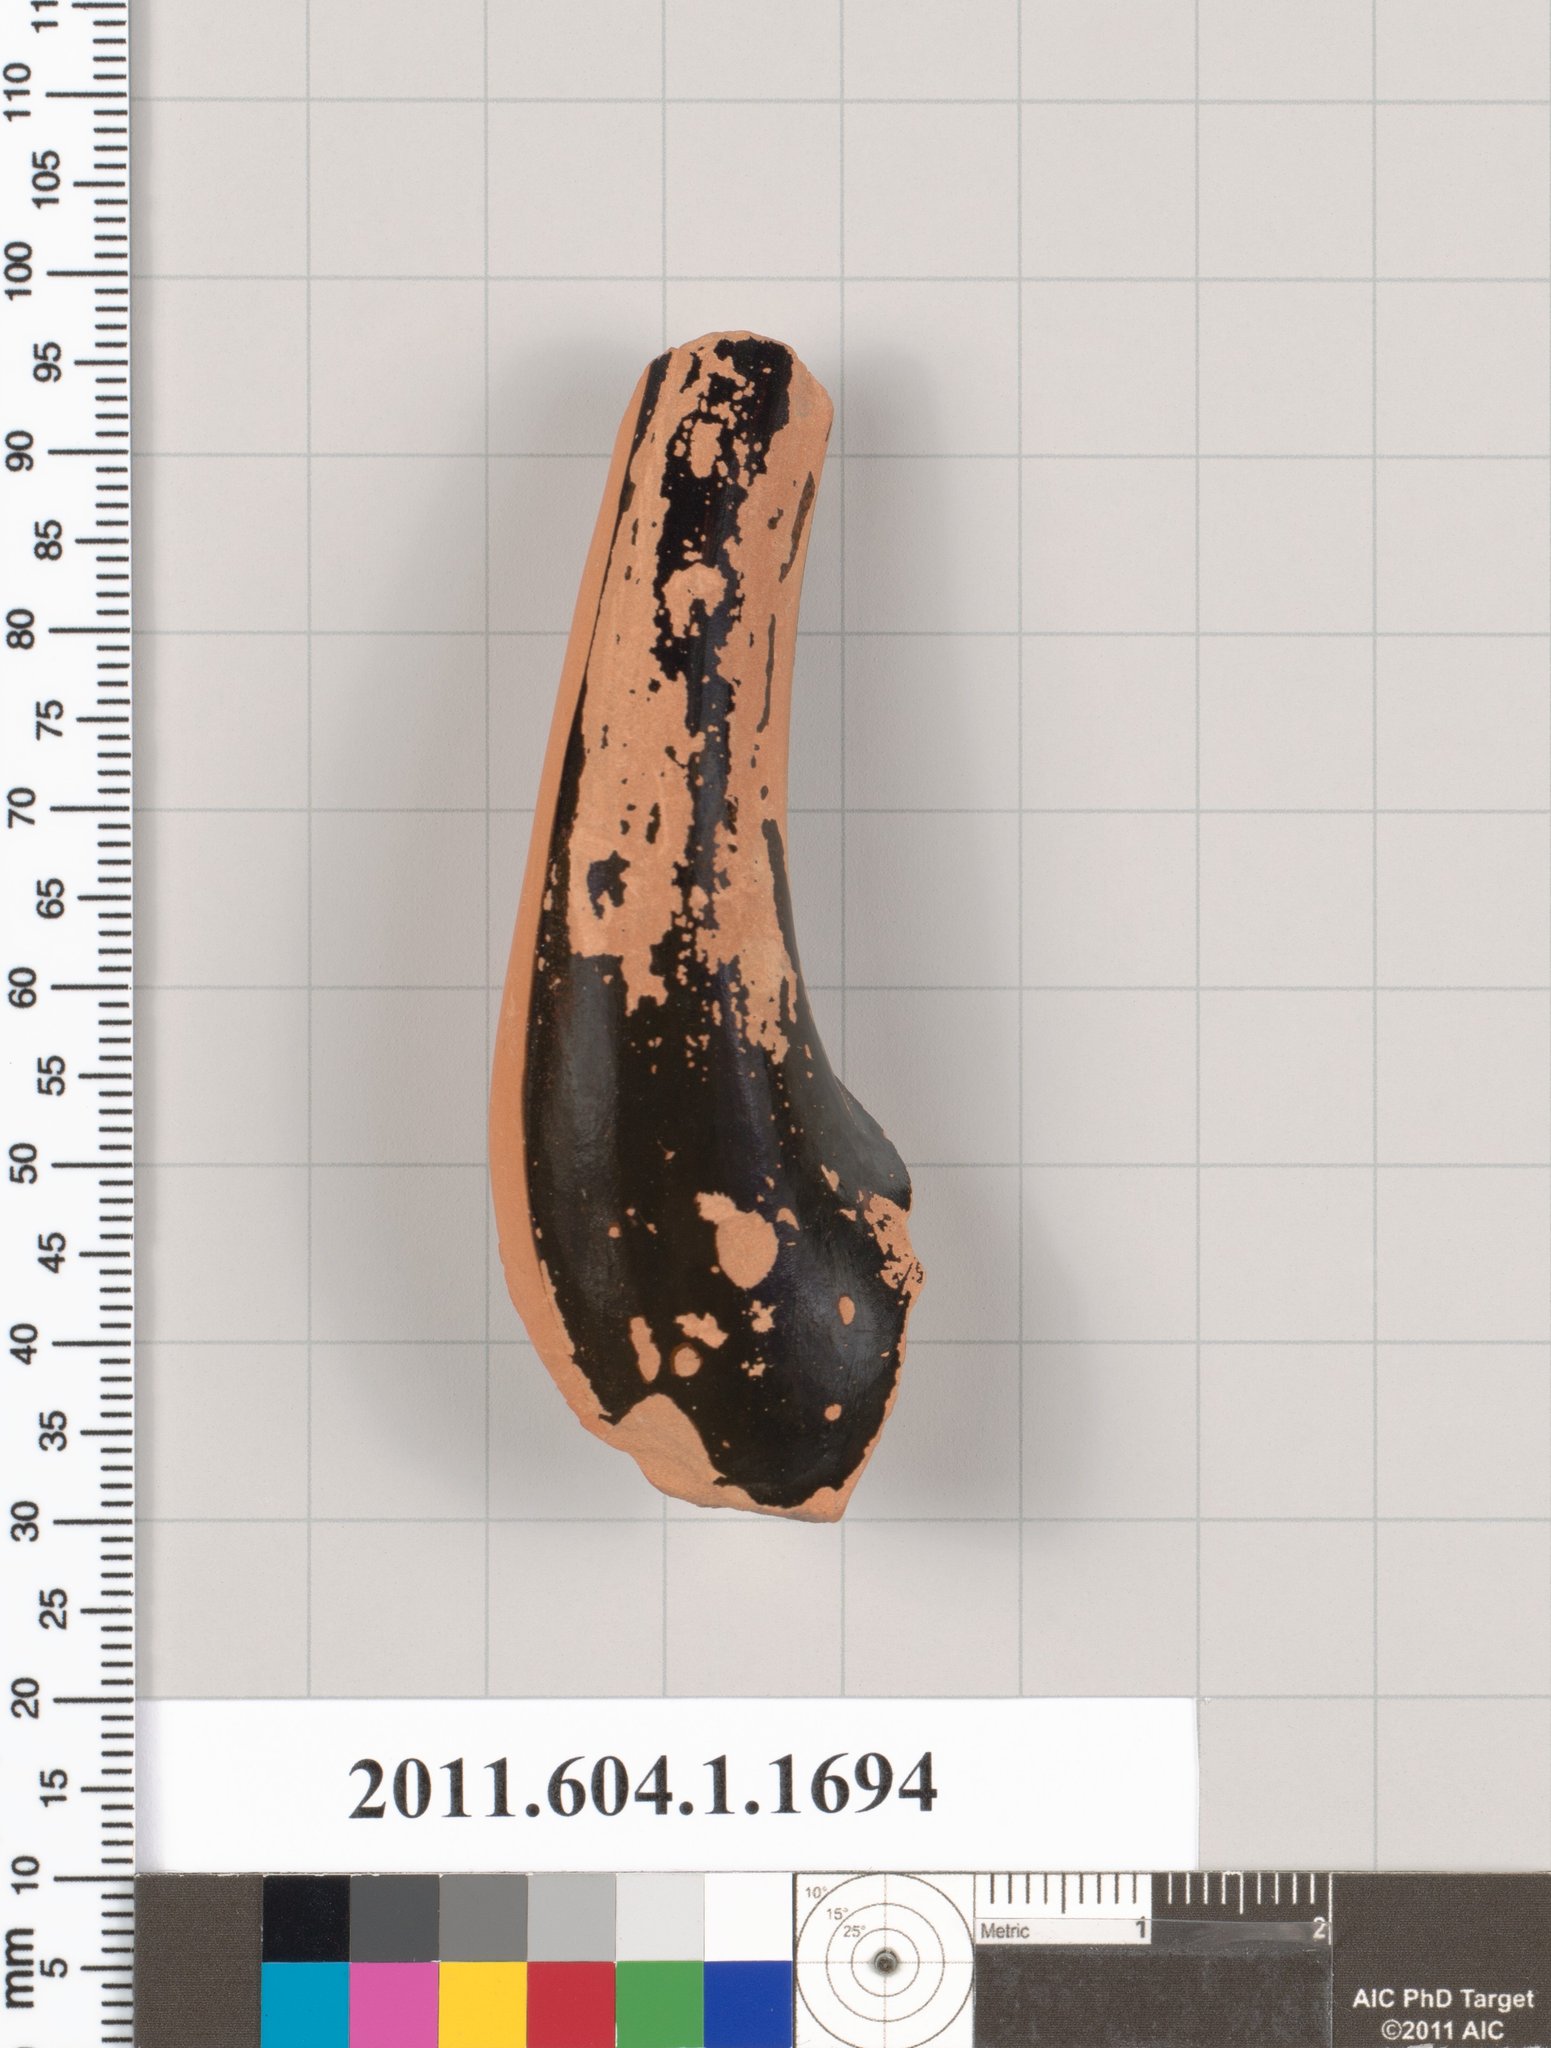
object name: kylix fragment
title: Terracotta fragment of a kylix (drinking cup)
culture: greek, attic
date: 500-401 BCE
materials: terracotta